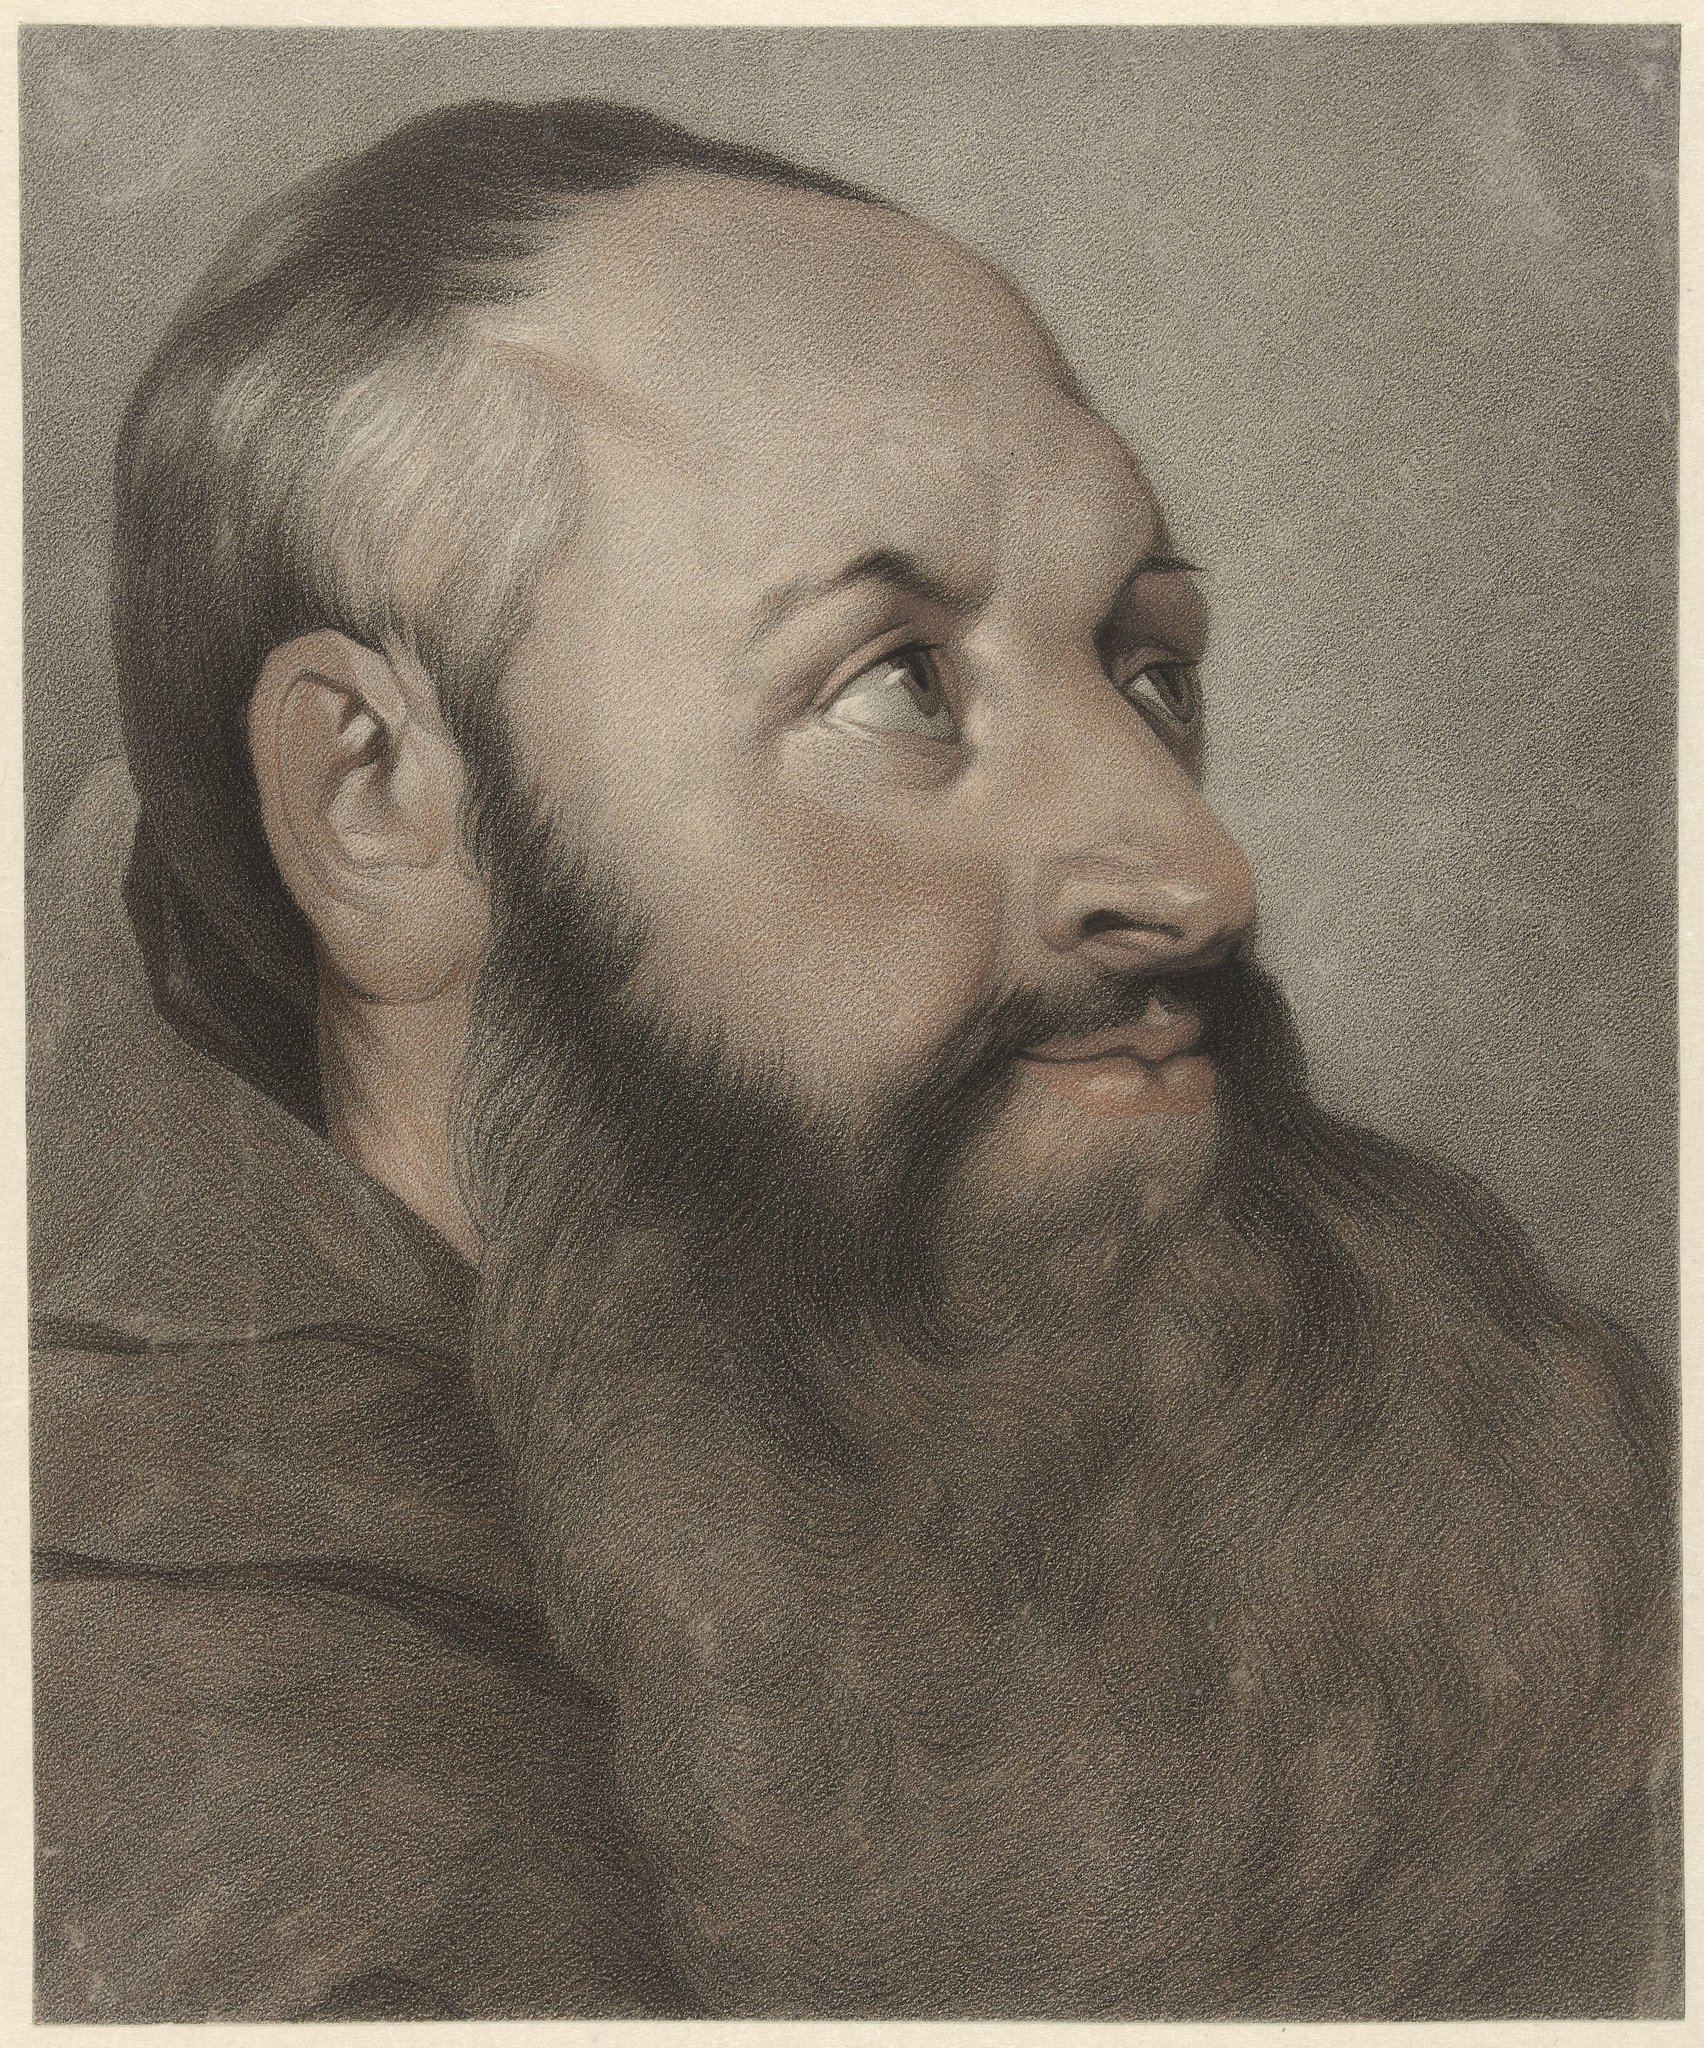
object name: drawing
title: Monnik, naar rechts, opziende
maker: johannes cornelis mertens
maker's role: draughtsman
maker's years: 1742-1823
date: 1752-1823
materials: chalk, paper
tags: monk(s), friar(s)